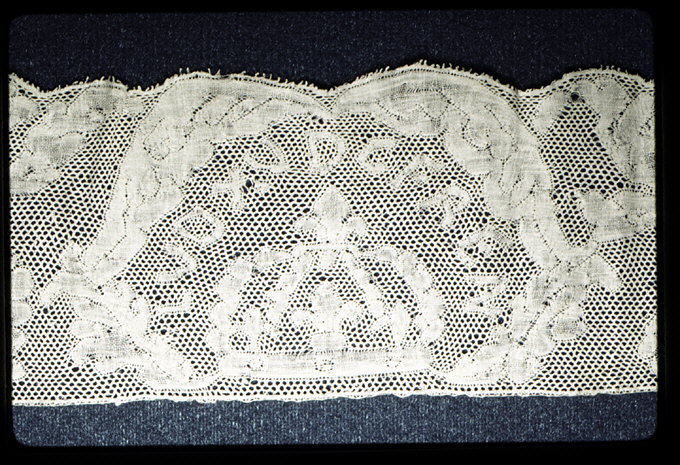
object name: sleeve trimming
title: Sleeve ruffle (Engageante)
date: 1701-1800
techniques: lace